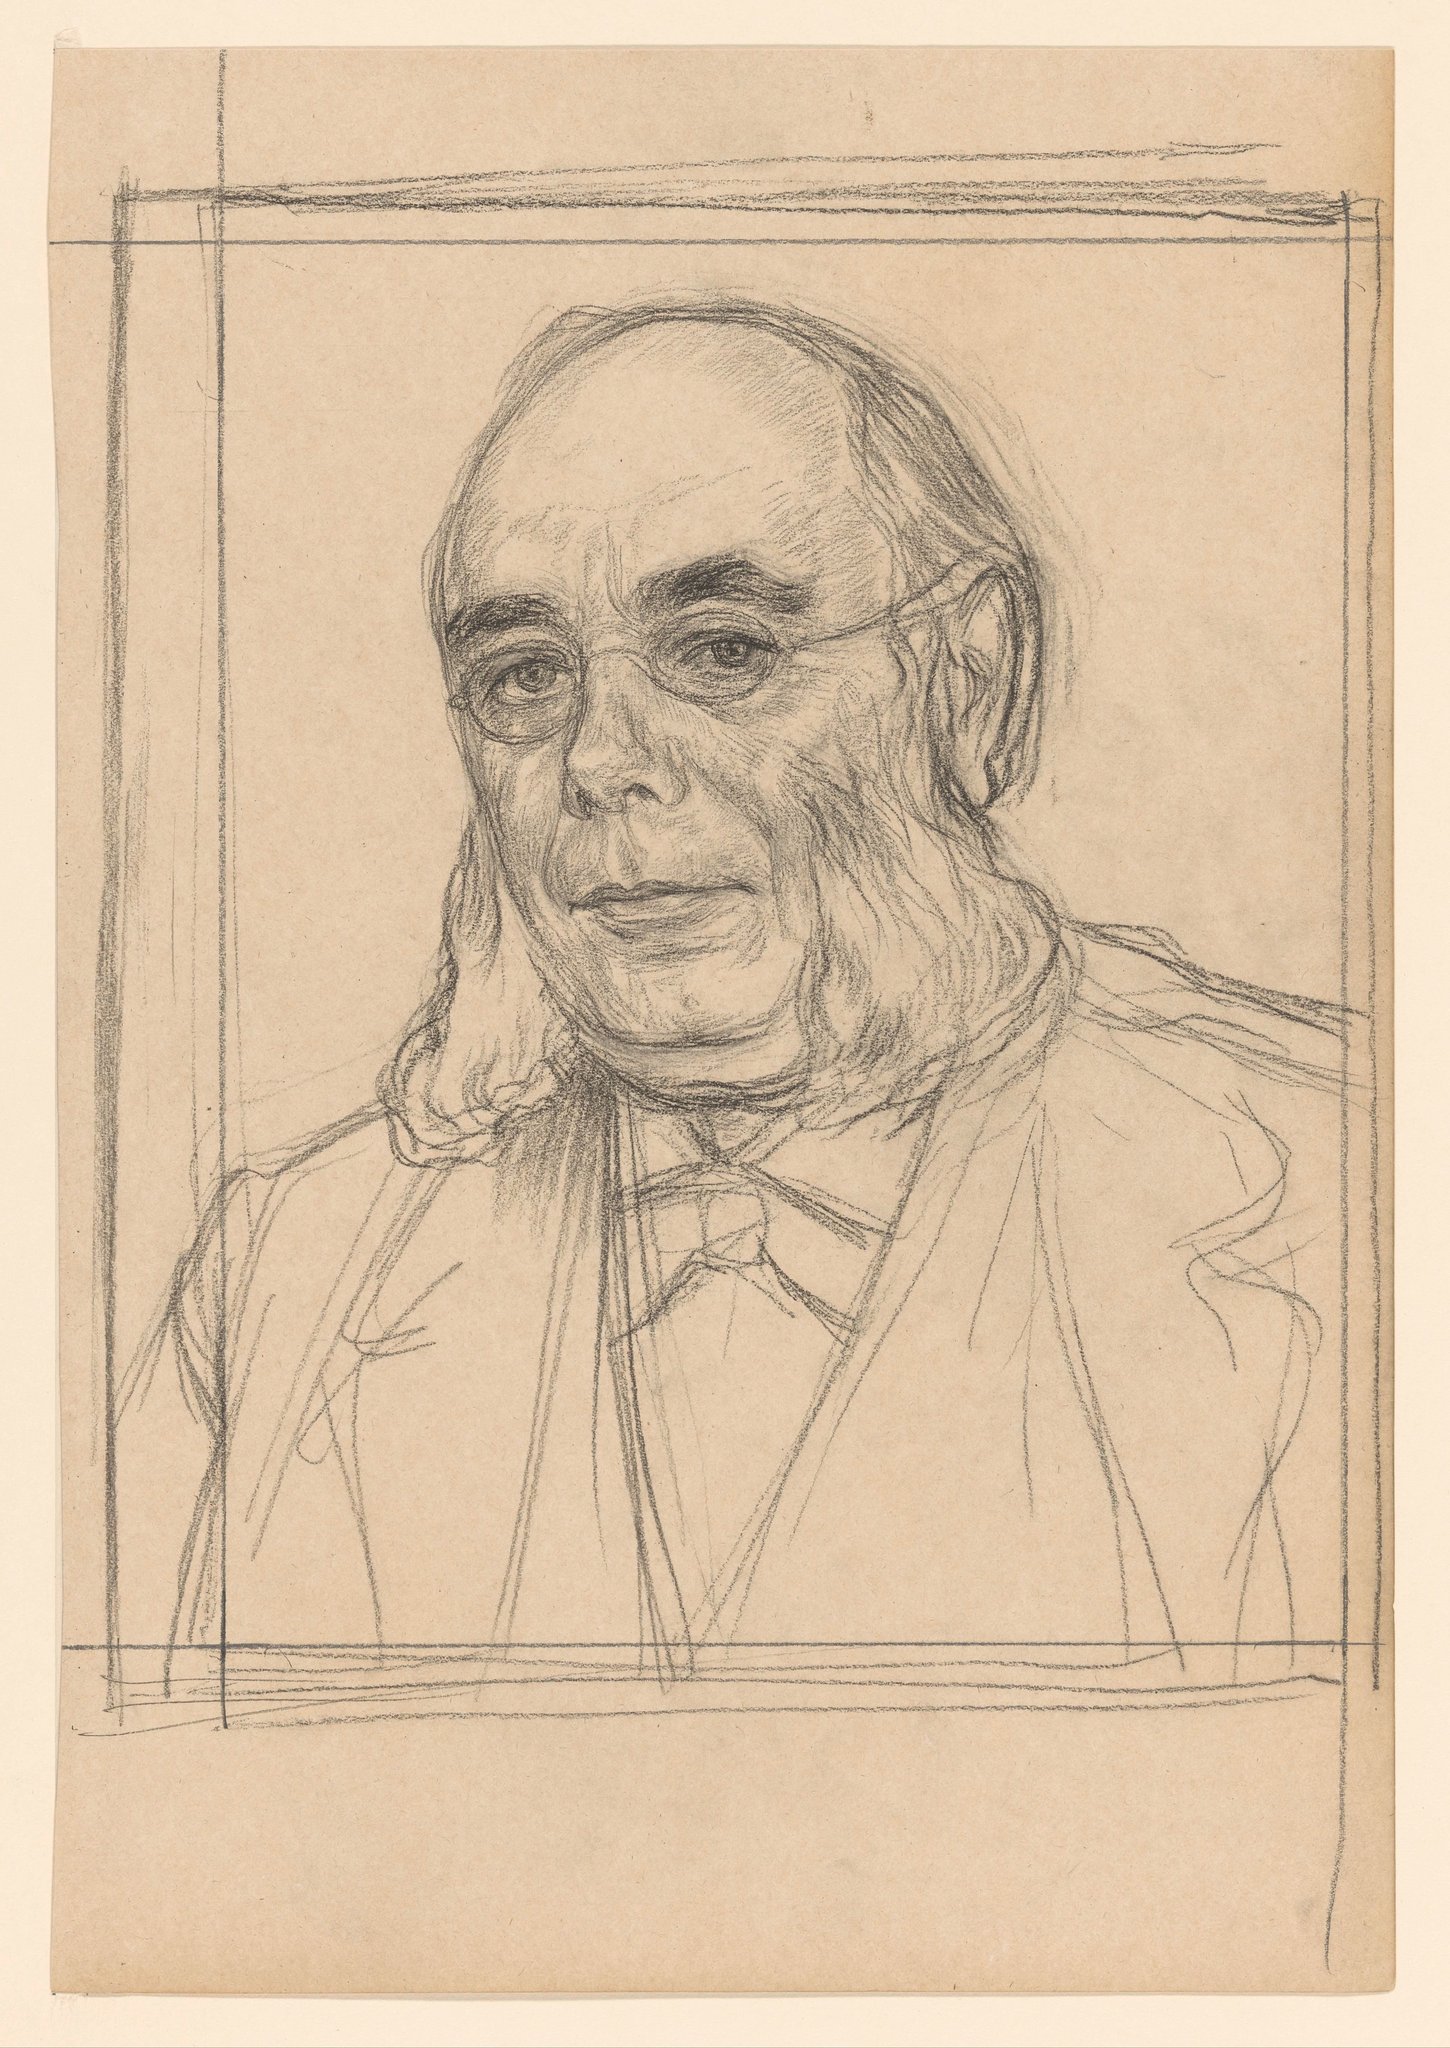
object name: drawing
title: Portret van dr. H. Pierson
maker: jan veth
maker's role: designer, draughtsman, painter, print maker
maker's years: 1864-1925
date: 1874-1925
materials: chalk, paper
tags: historical persons